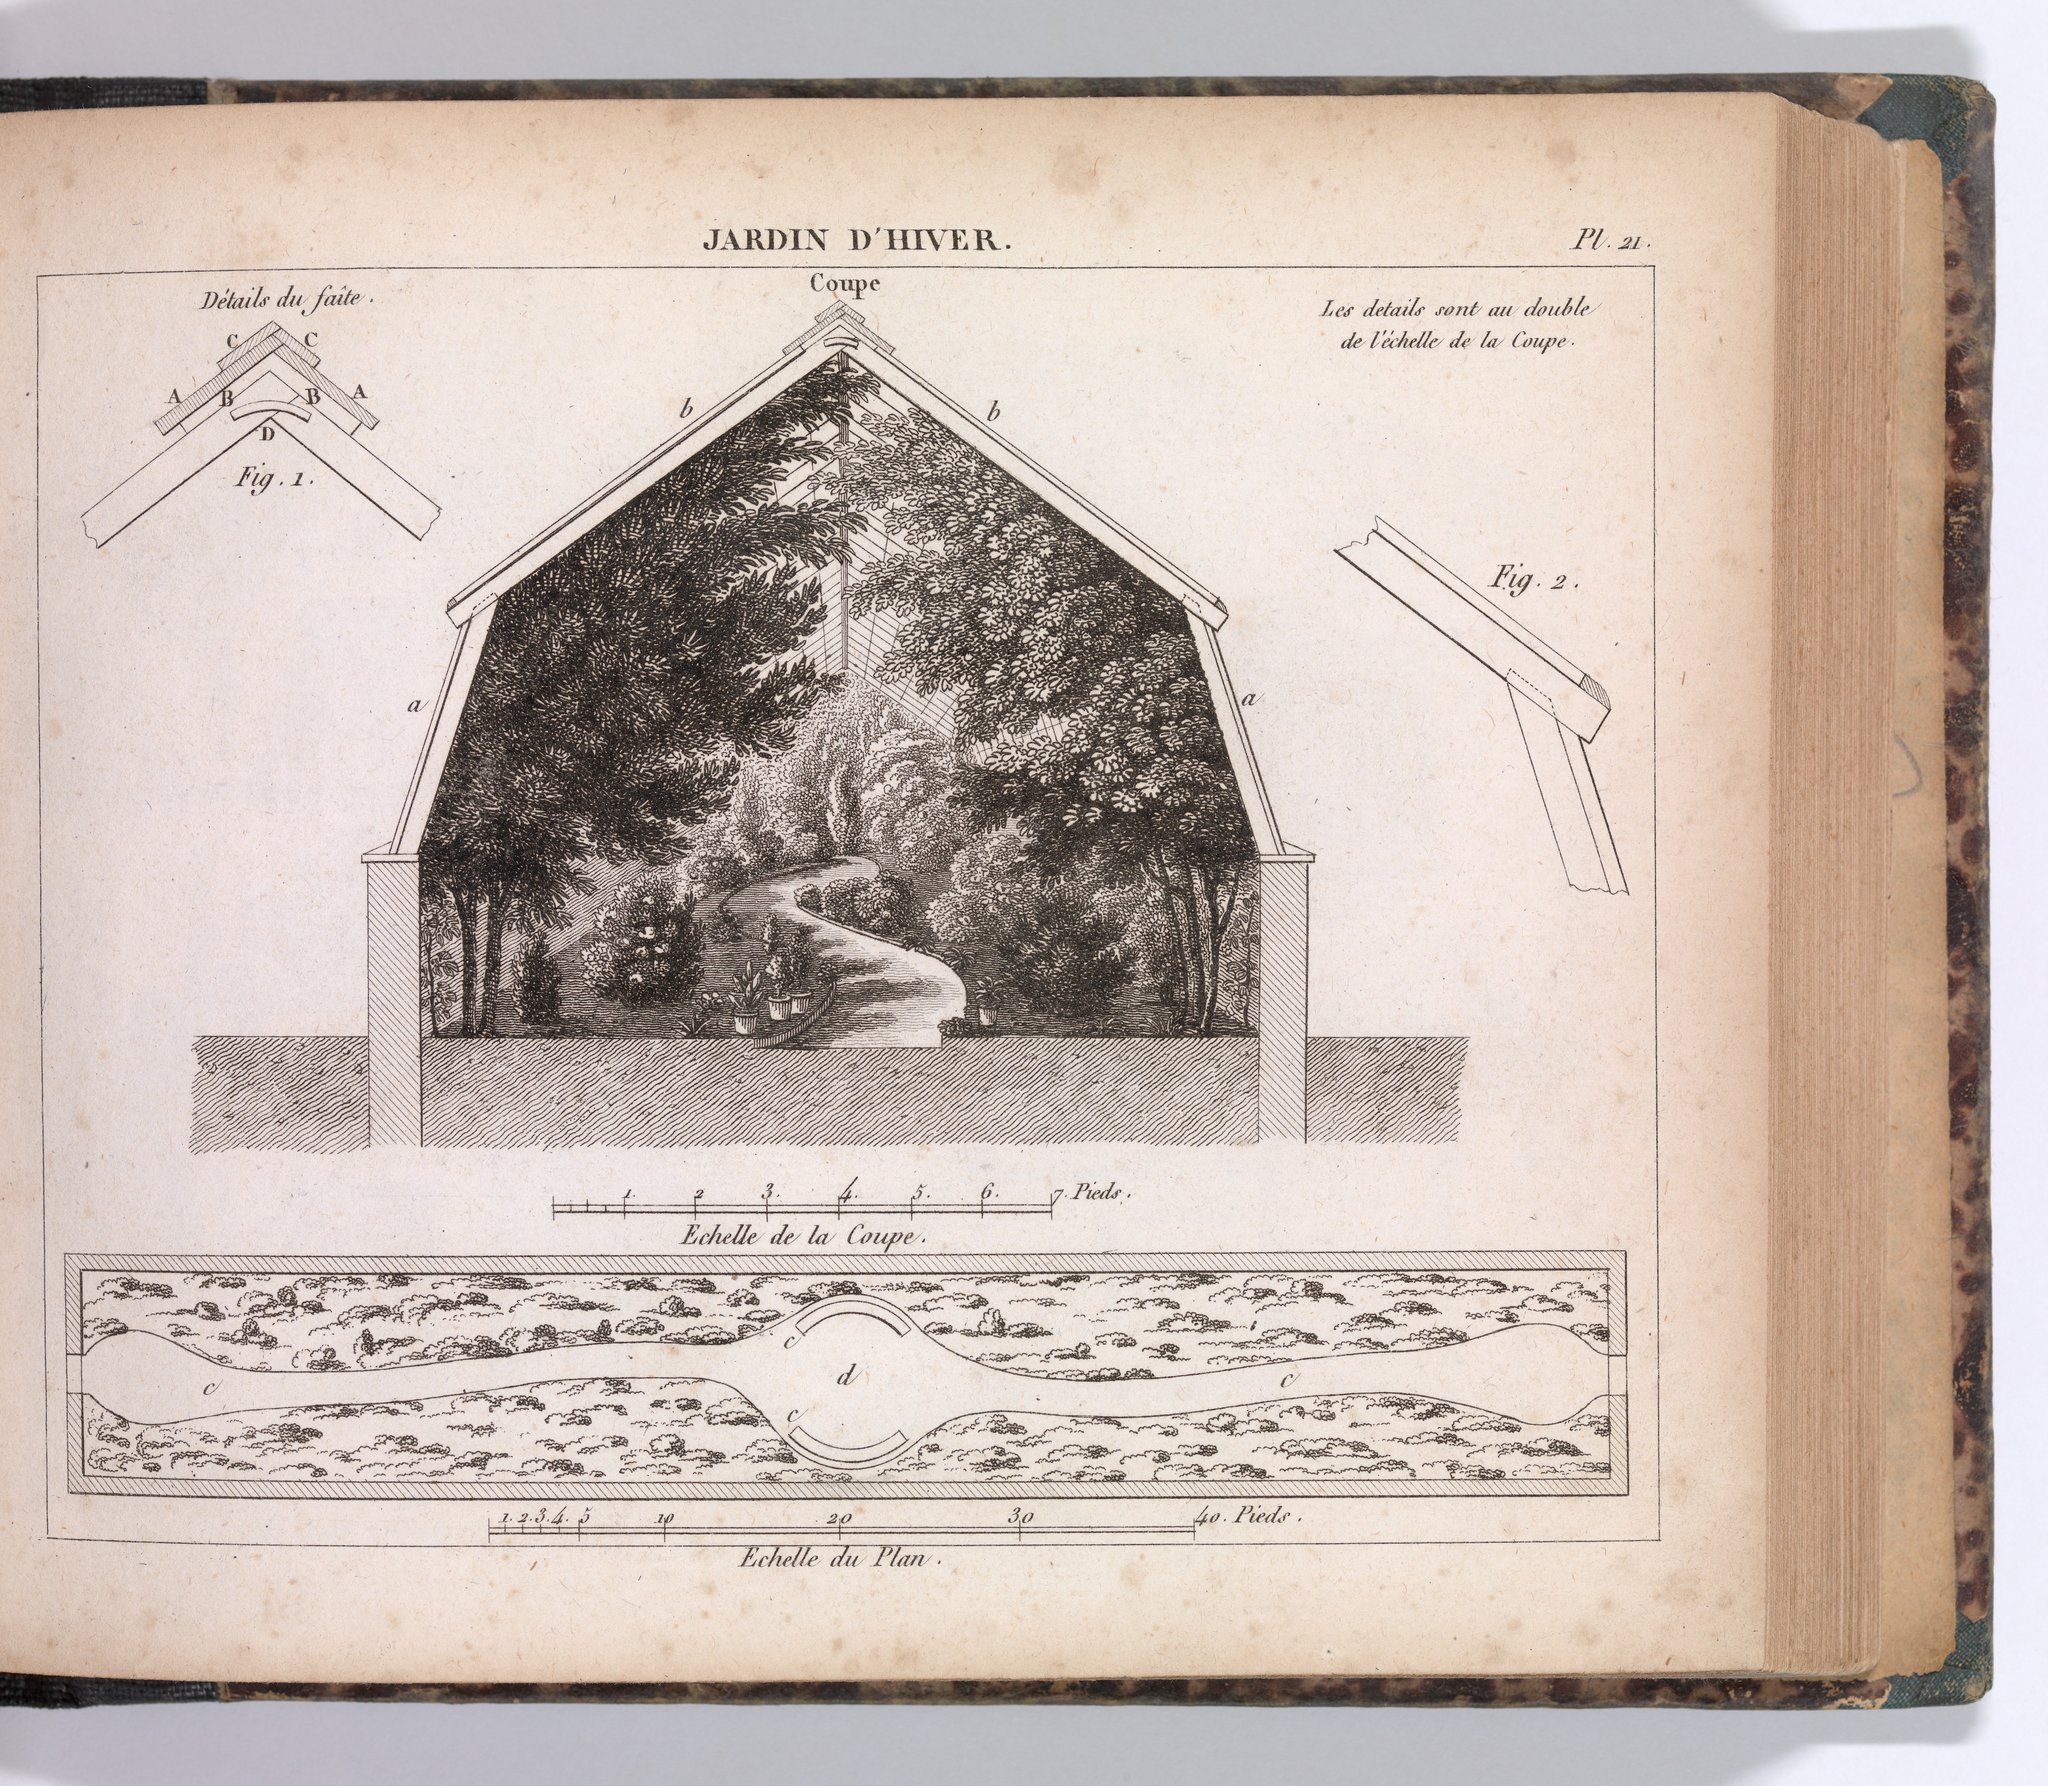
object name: book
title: Traité de la composition de l'ornement des jardins, avec 96 planches representant des plans de jardins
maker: pierre boitard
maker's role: author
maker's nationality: french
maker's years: 1789-1859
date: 1825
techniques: engraving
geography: france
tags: architecture,gardens